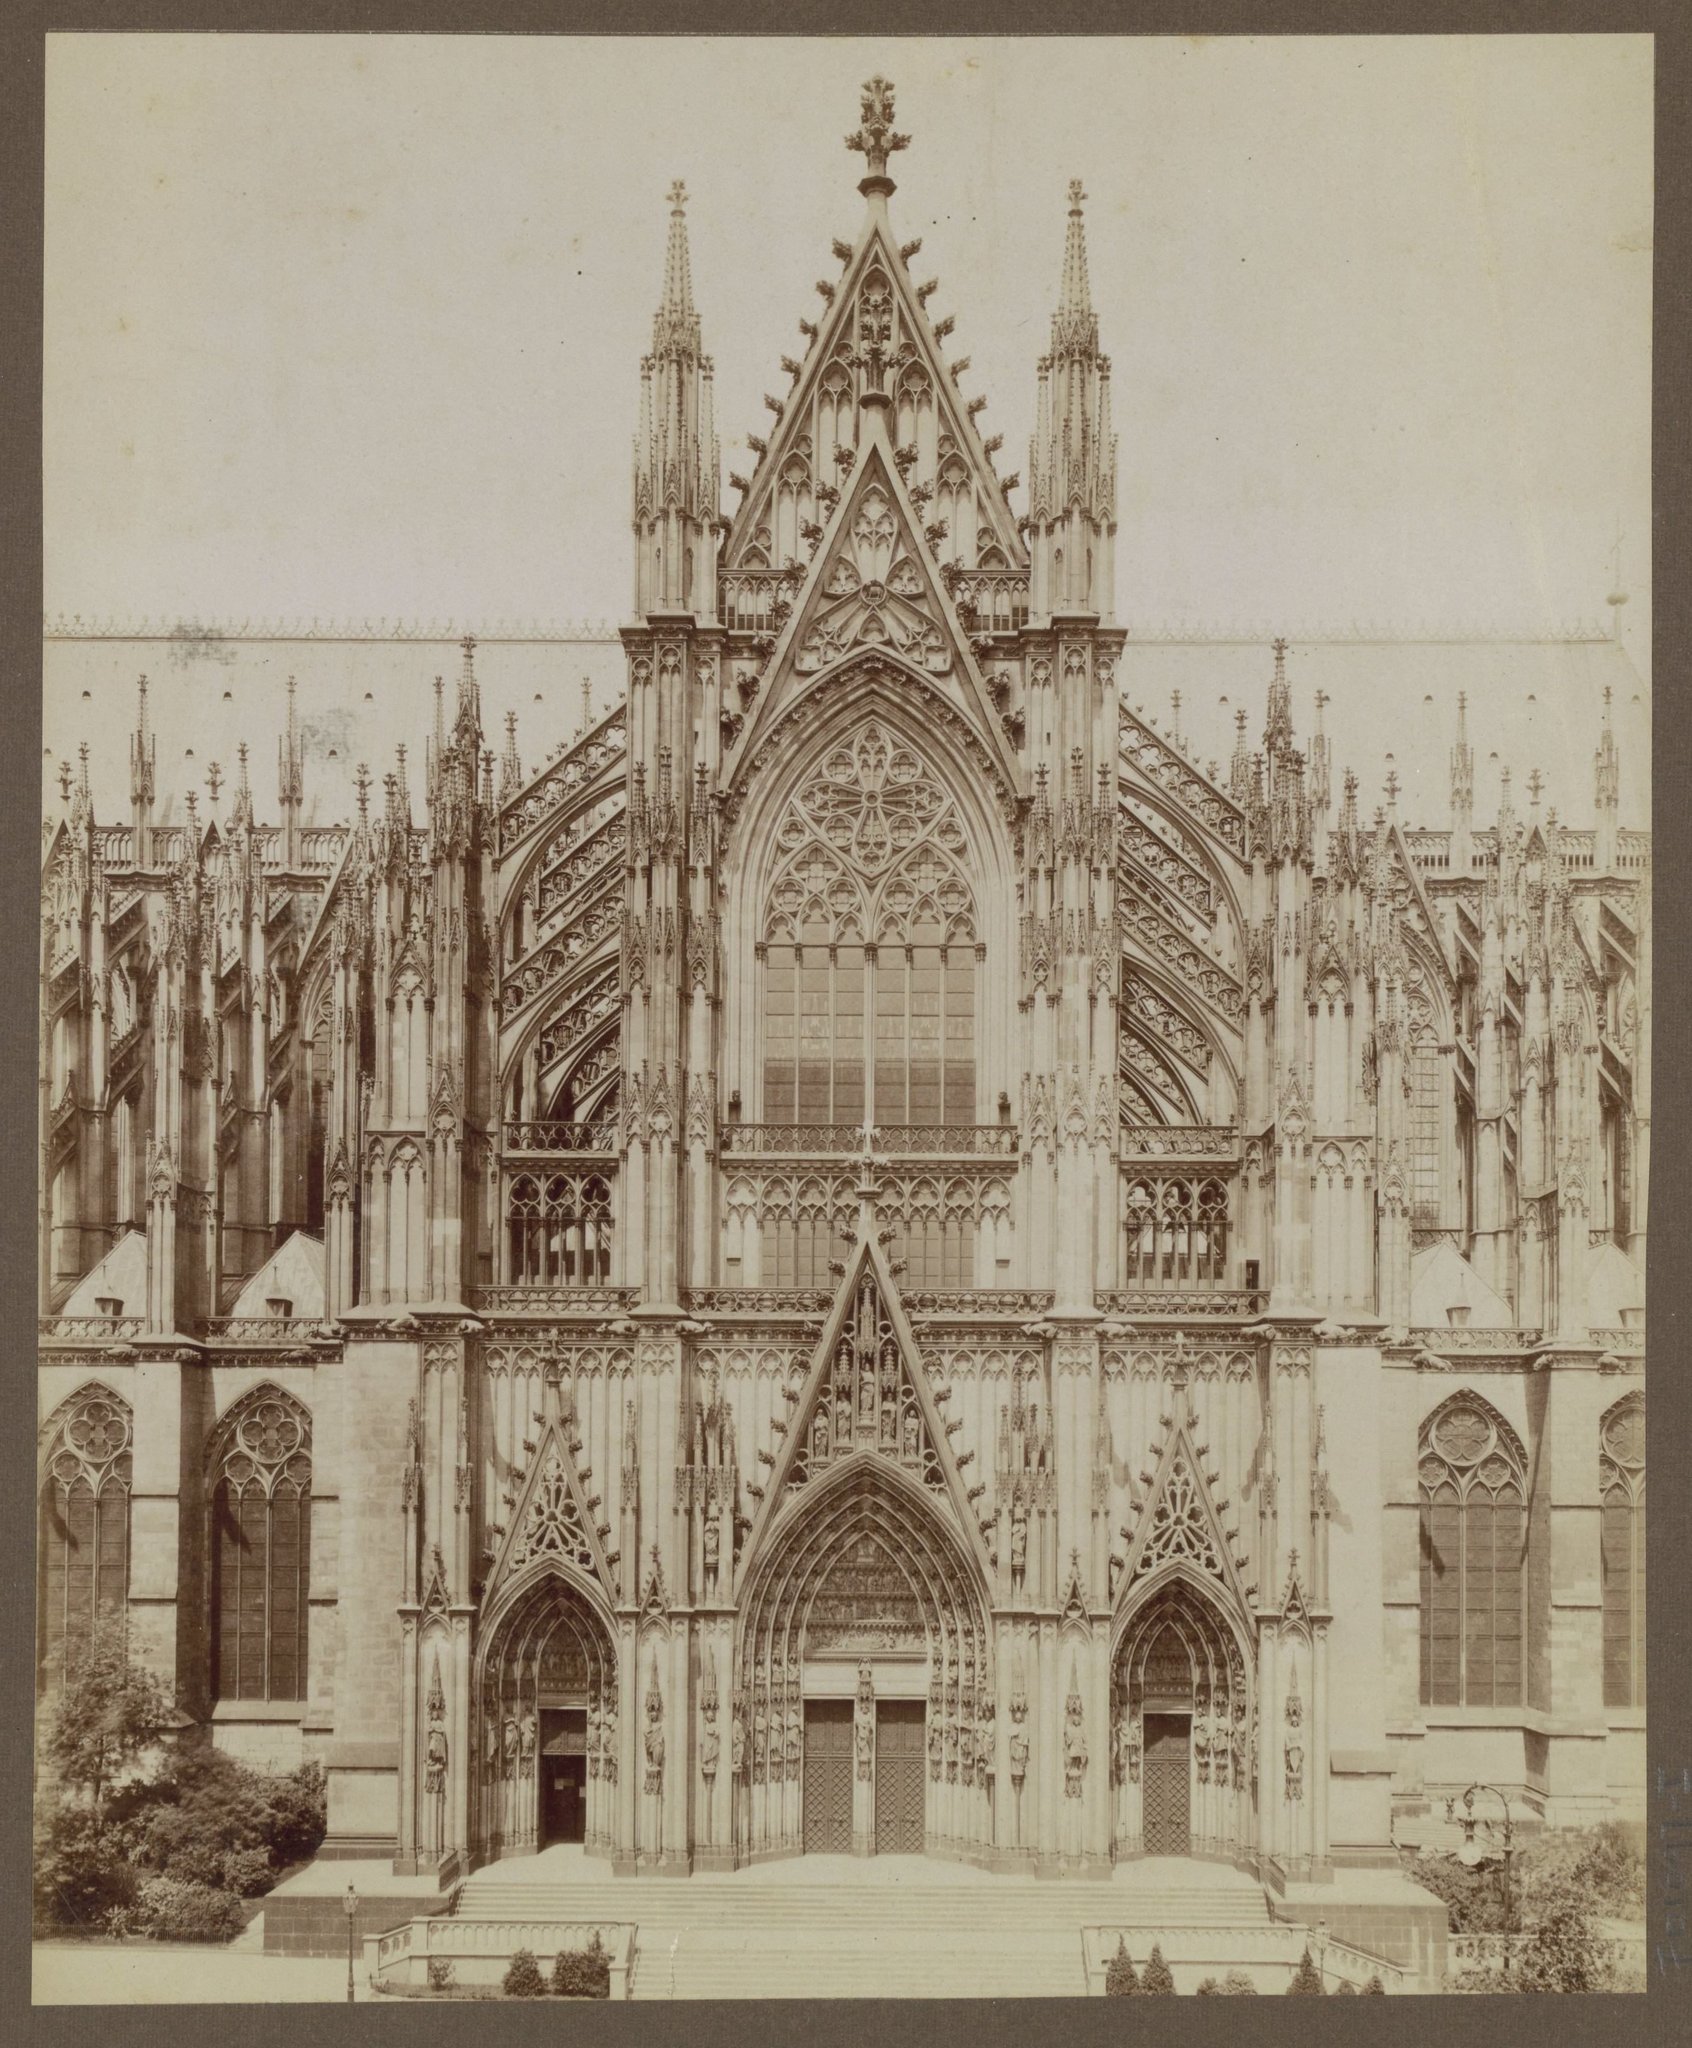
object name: photograph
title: Portaal van de Dom van Keulen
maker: johann heinrich schönscheidt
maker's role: fotograaf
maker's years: 1835-1903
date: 1880-1900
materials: paper, photographic support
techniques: albumen print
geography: cologne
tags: parts of church exterior and annexes: portal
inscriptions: check stamp: ‘JH Schönscheidt’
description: Onderdeel van Reisalbum met foto's van Duitsland, Zwitserland, het Suezkanaal en Nederlands-Indië.